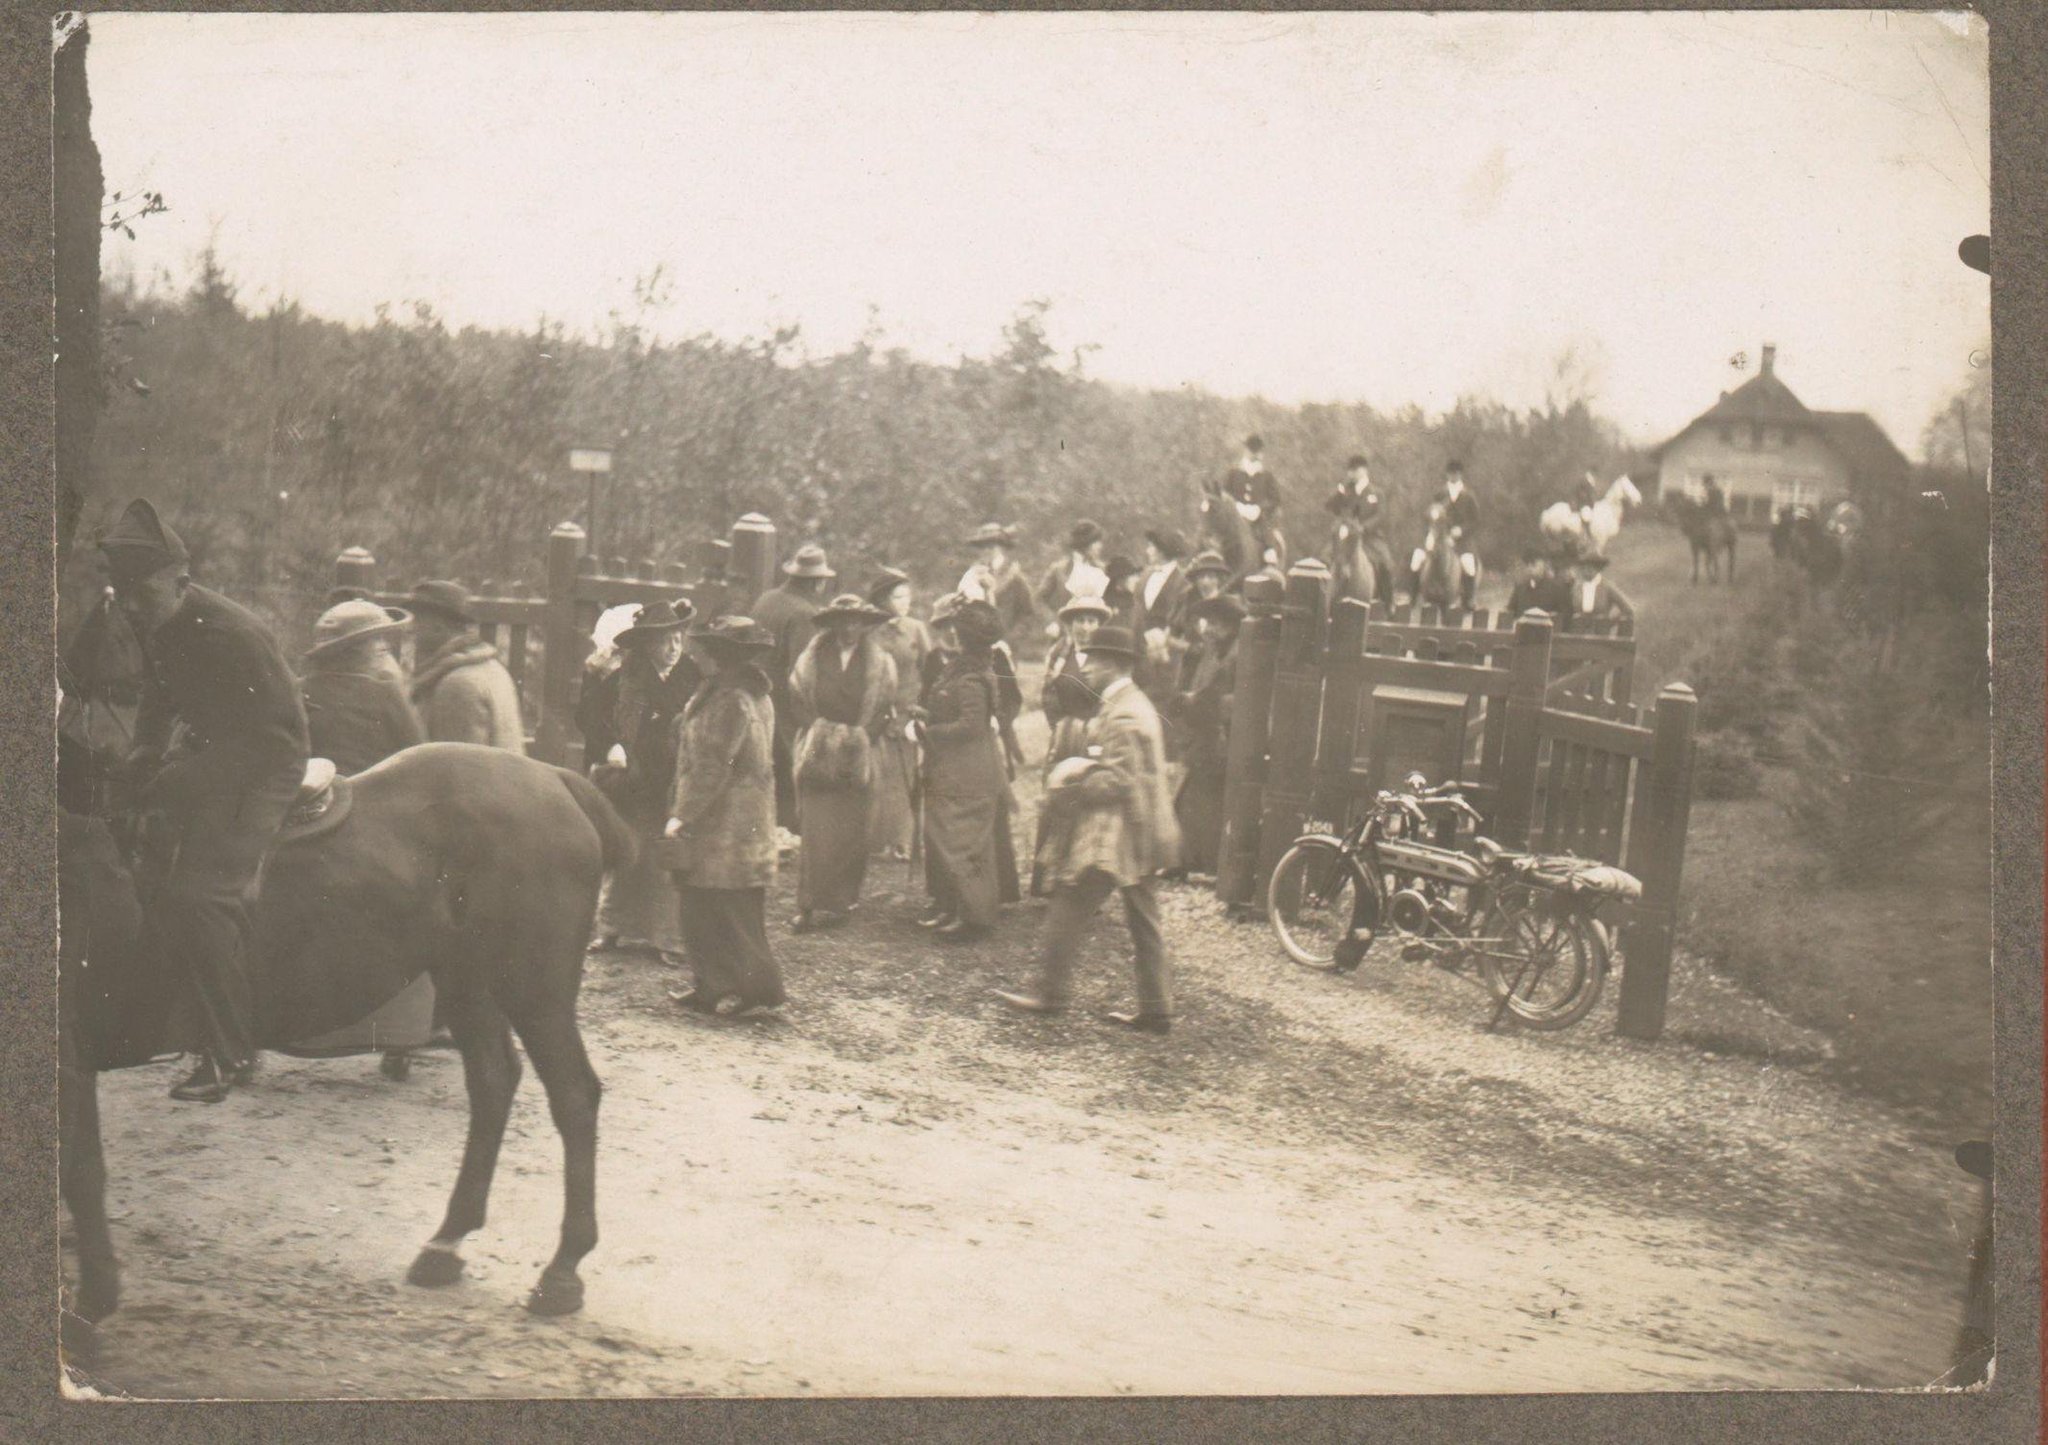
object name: photograph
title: Ruitertafereel op Koninklijke Houtvesterij Het Loo: ruiters met publiek bij een hek en een motorfiets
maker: Anonymous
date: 1900-1925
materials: photographic support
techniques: gelatin silver print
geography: het loo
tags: riding a horse, ass, or mule; rider, horseman, hunting, chase, motor-cycles and other two-wheeled motor-vehicles, hunting-ground, fence, wall, paling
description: Onderdeel van Fotoalbum van de heer Brams, opperhoutvester van koningin Wilhelmina op Koninklijke Houtvesterij Het Loo.